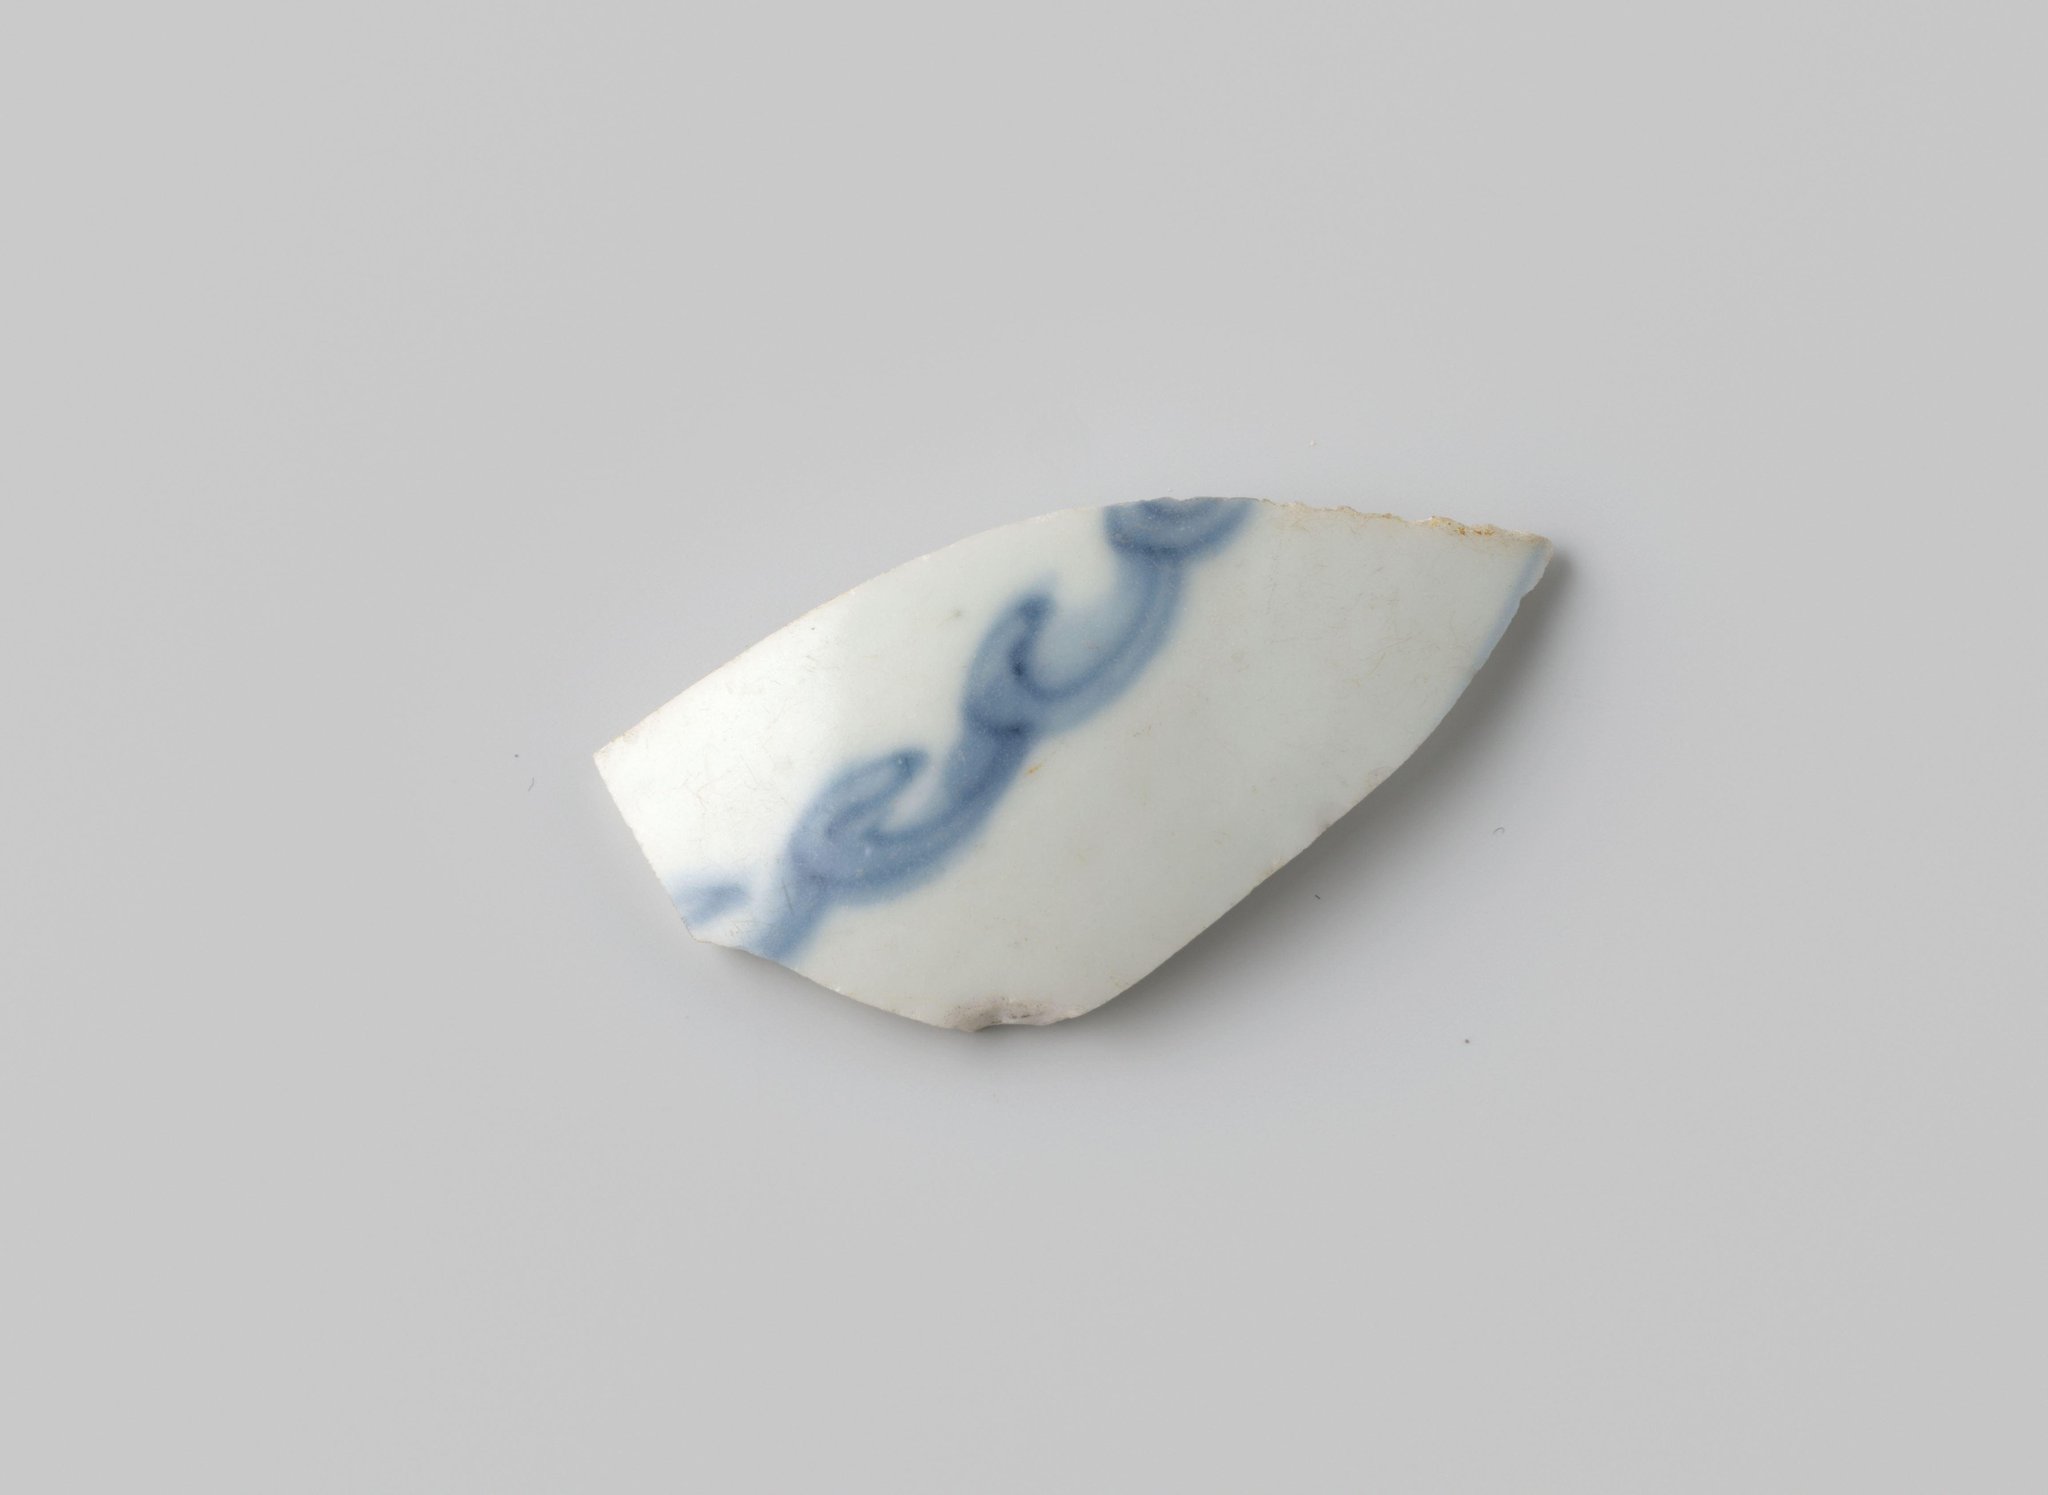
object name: sherd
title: Scherf van een kom uit V.O.C.-schip de 'Witte Leeuw'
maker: Anonymous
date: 1613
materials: porcelain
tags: verenigde oostindische compagnie, sint-helena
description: Scherf van een kom uit V.O.C.-schip de 'Witte Leeuw'.